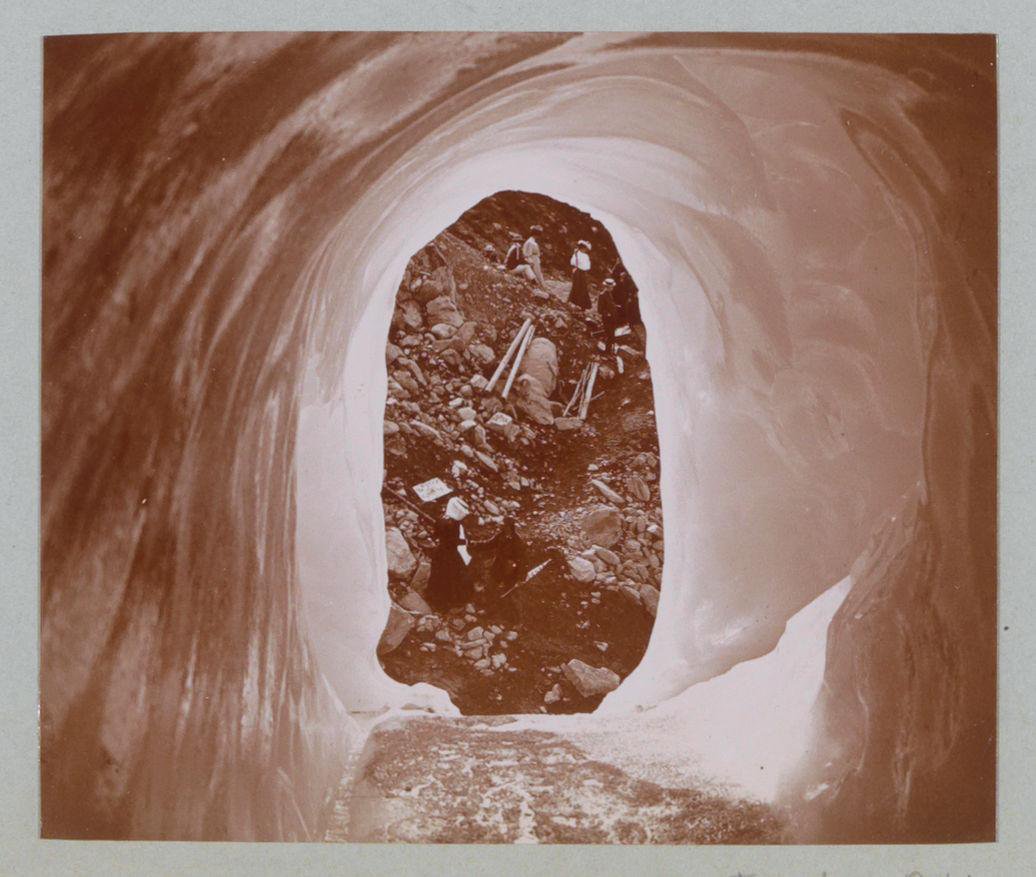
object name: photograph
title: Wandelaars in de Alpen, gezien door een gat in het ijs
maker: Anonymous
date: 1905-1910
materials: paper, photographic support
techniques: gelatin silver print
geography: alps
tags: walking, hiking (recreation), glacier, ice ~ state of water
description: Onderdeel van Fotoalbum van een Franse amateurfotograaf met bezienswaardigheden in Frankrijk, Zwitserland en Italië.